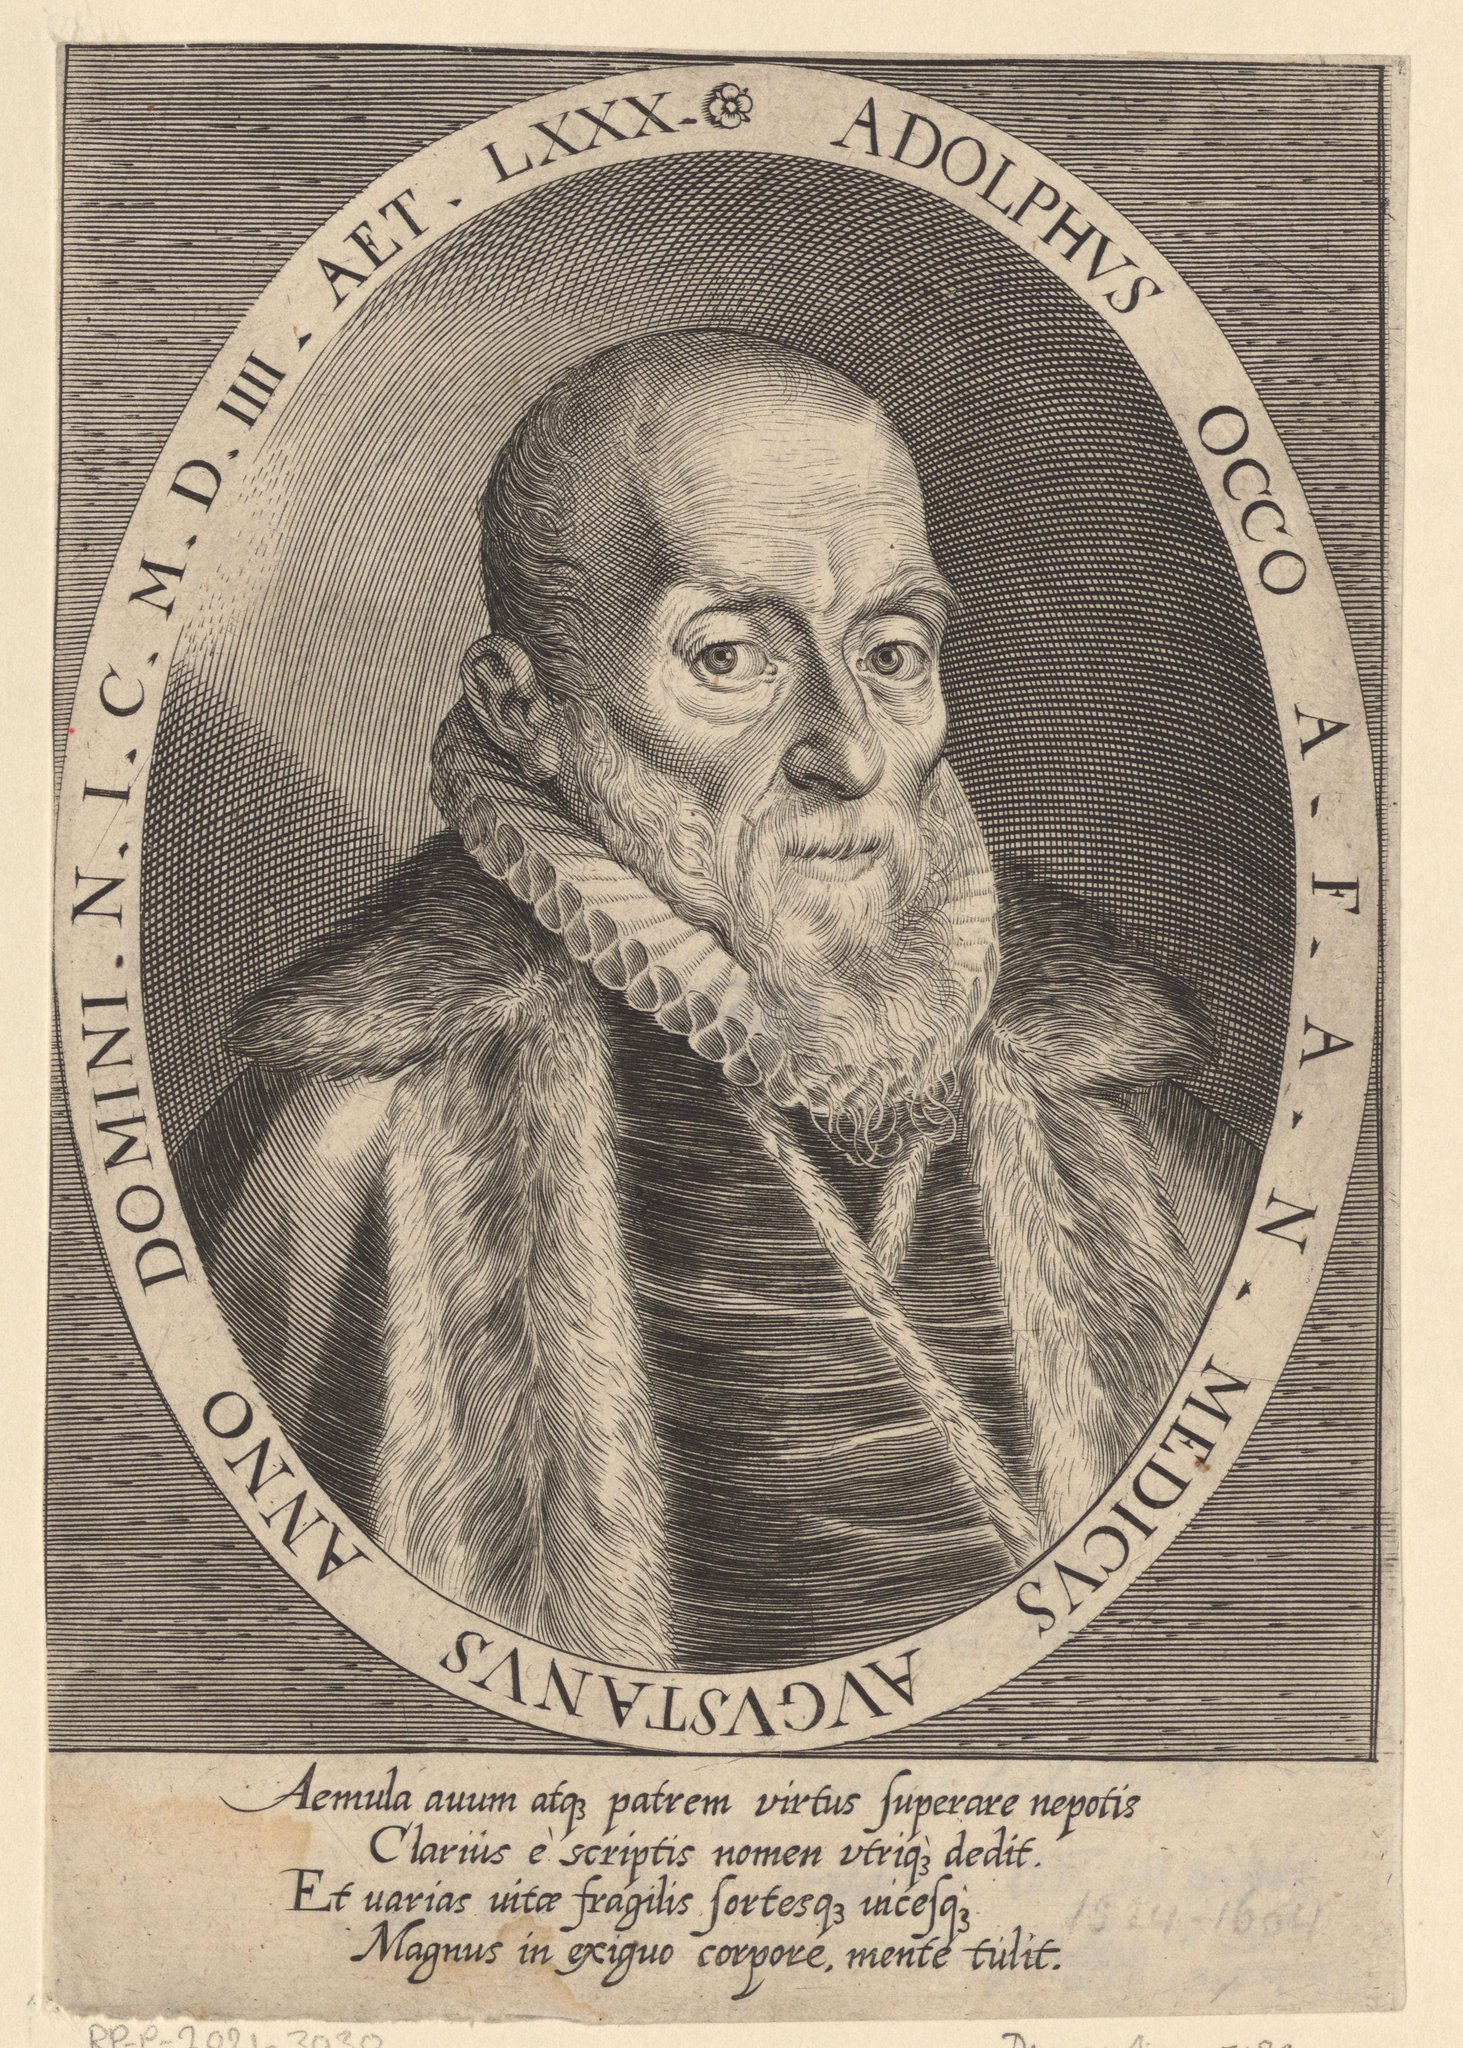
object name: print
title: Portret van Adolph Occo III op 53-jarige leeftijd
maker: dominicus custos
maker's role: print maker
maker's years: 1560-1615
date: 1604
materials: paper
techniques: engraving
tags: adolph occo (iii), historical persons